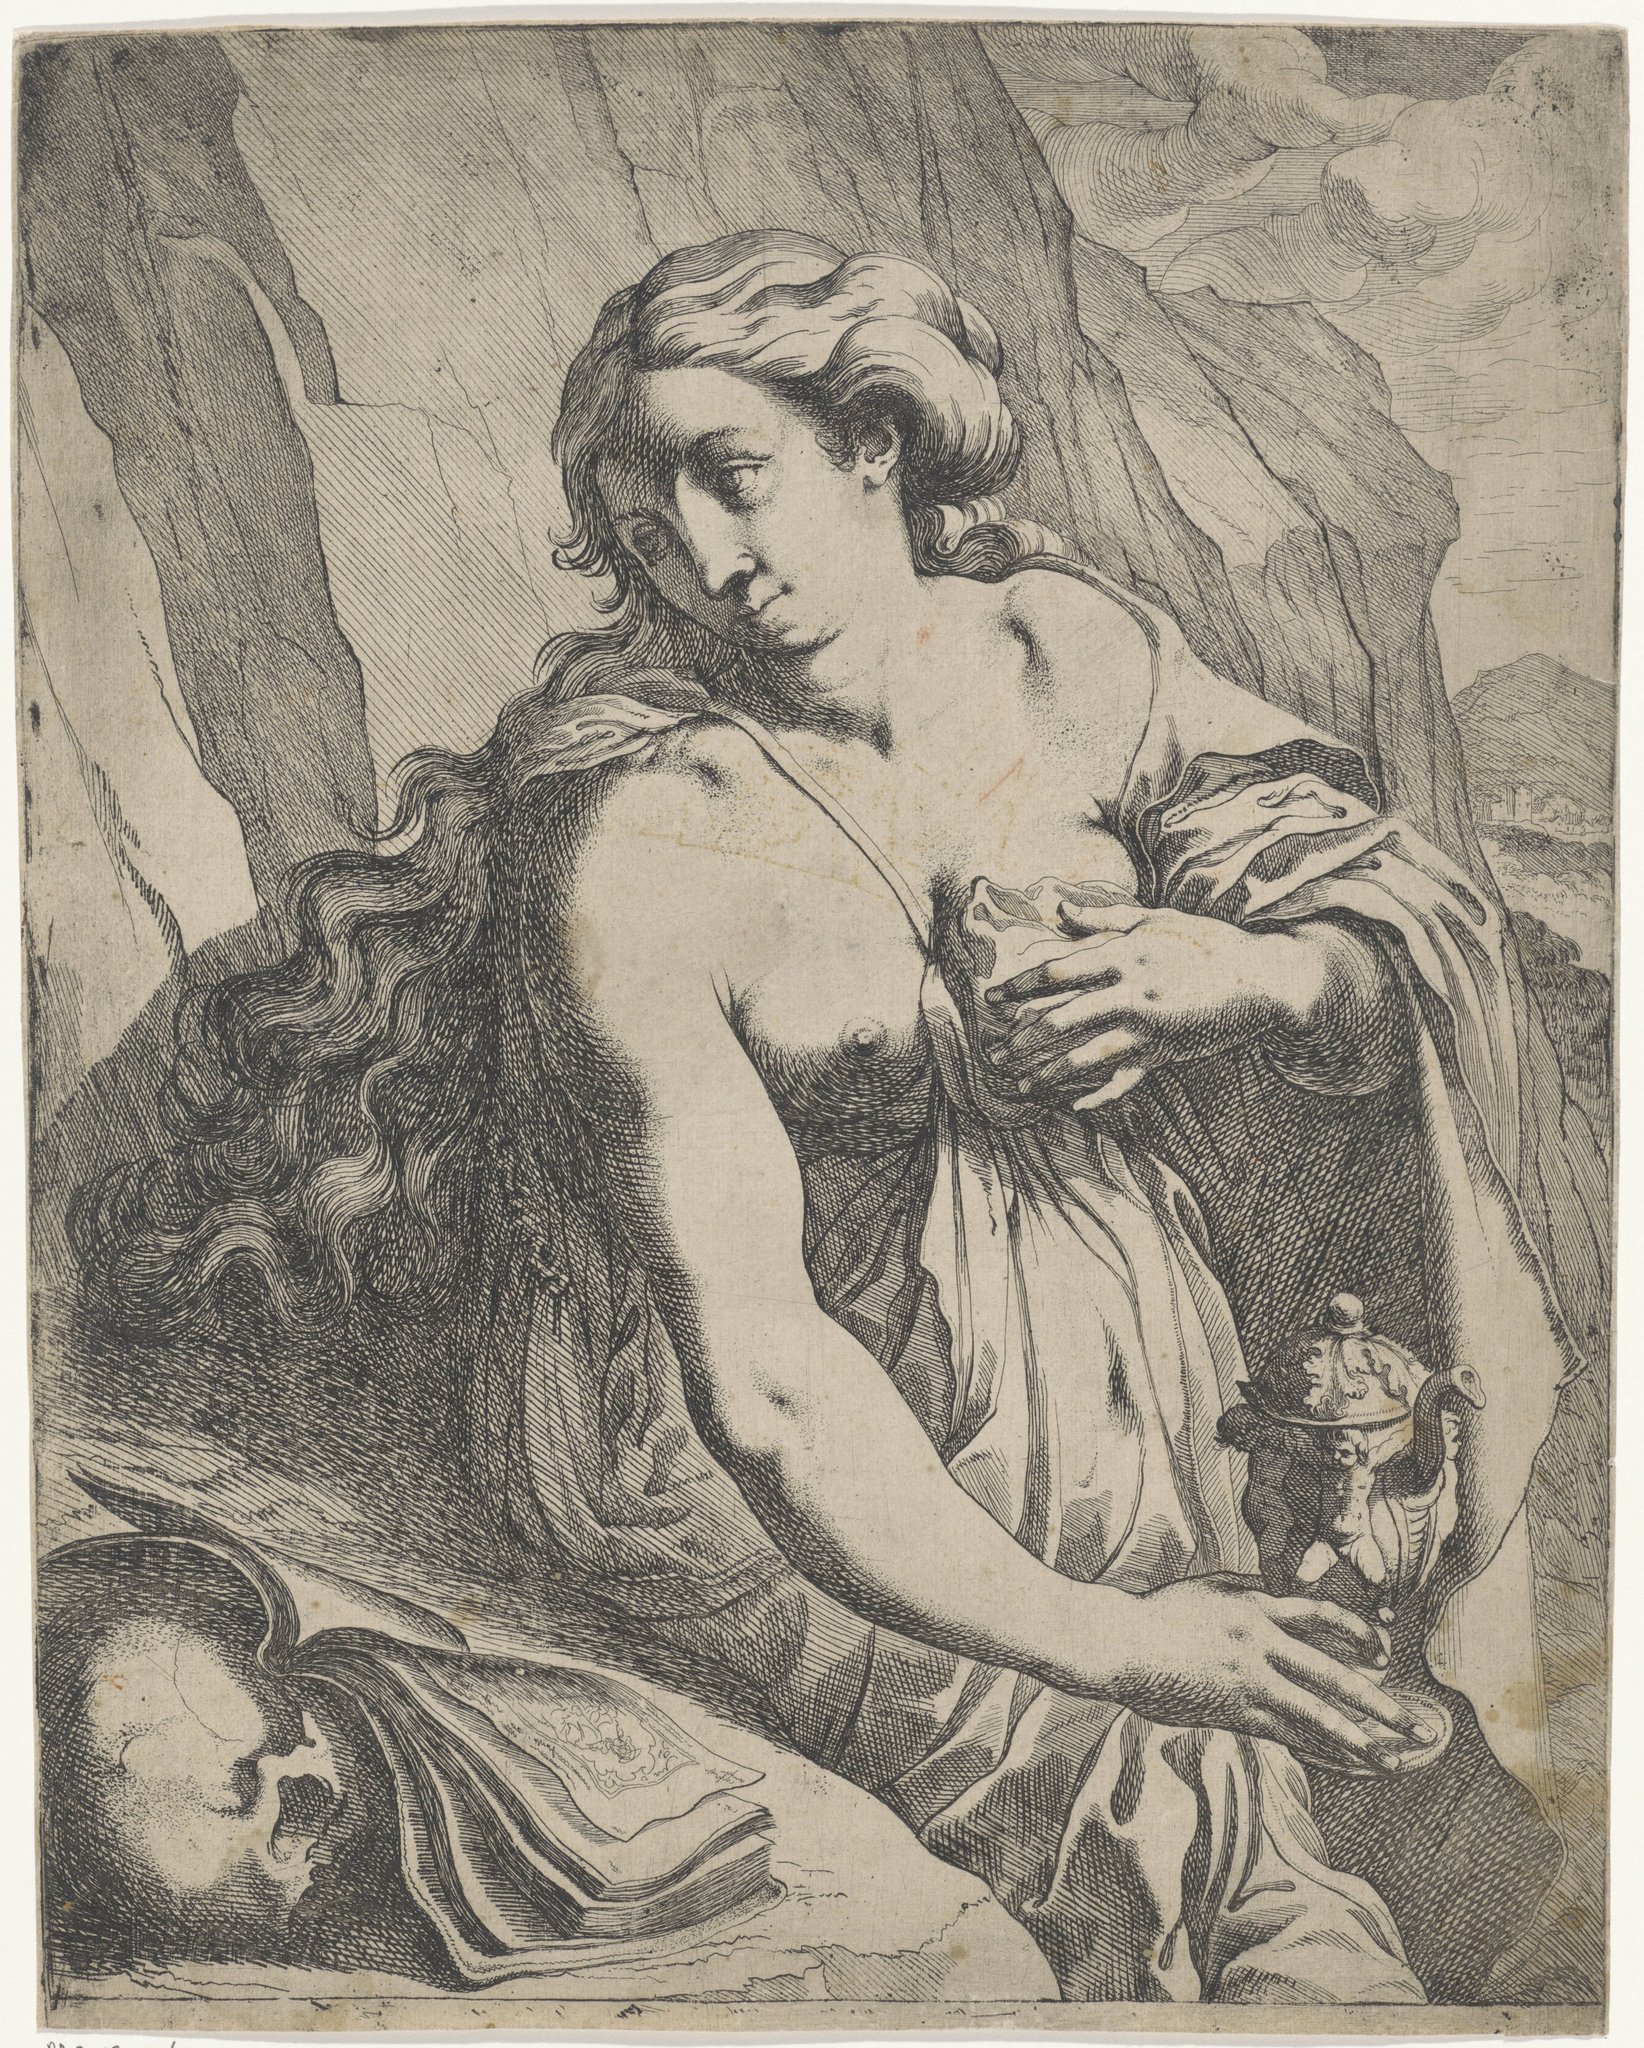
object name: print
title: Boetvaardige Maria Magdalena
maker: werner van den valckert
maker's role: draughtsman, painter, print maker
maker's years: 1580-1627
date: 1610-1612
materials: paper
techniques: engraving, etching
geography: the hague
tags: the penitent st. mary magdalene (often before a cave, possibly at la sainte-baume hill): her long hair covers her (naked) body, she reads, meditates or raises her tear-filled eyes towards heaven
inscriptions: collector's mark: Lugt 240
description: Maria Magdalena in een rotsachtig landschap, met haar zalfpot. Voor haar een opengeslagen boek op een schedel.